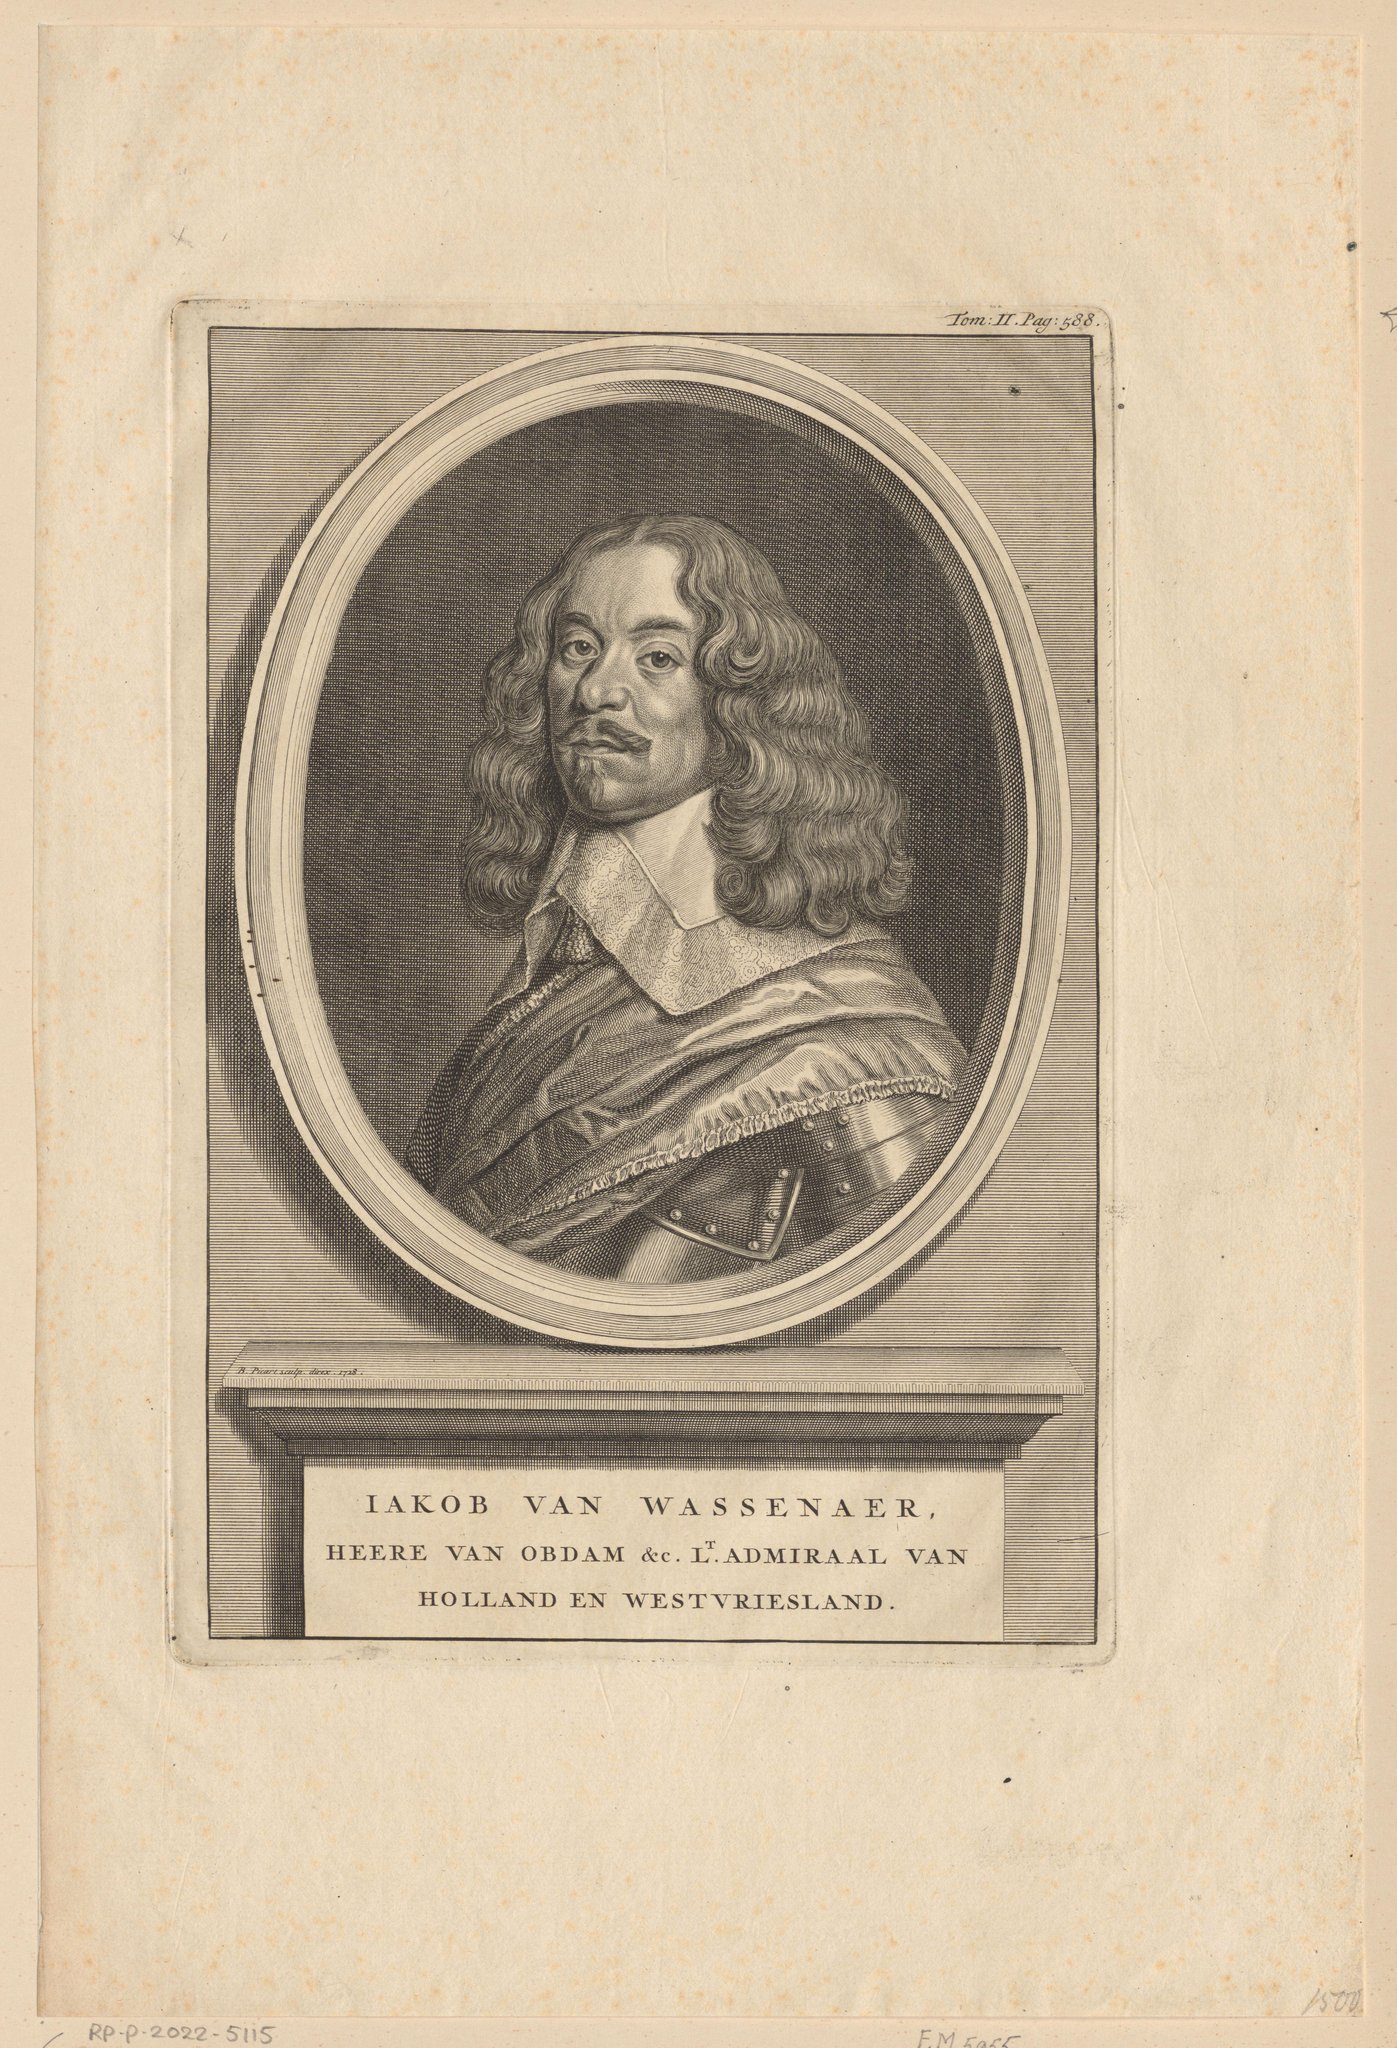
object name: print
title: Portret van Jacob, baron van Wassenaer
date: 1728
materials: paper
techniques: engraving, etching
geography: amsterdam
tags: jacob baron van wassenaer heer van obdam, armour, historical persons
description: Prent uit: Le Clerc, Jean. Geschiedenissen der Vereenigde Nederlanden. Amsterdam: Zacharias Chatelain (II), 1730, dl. 2, p. 588.